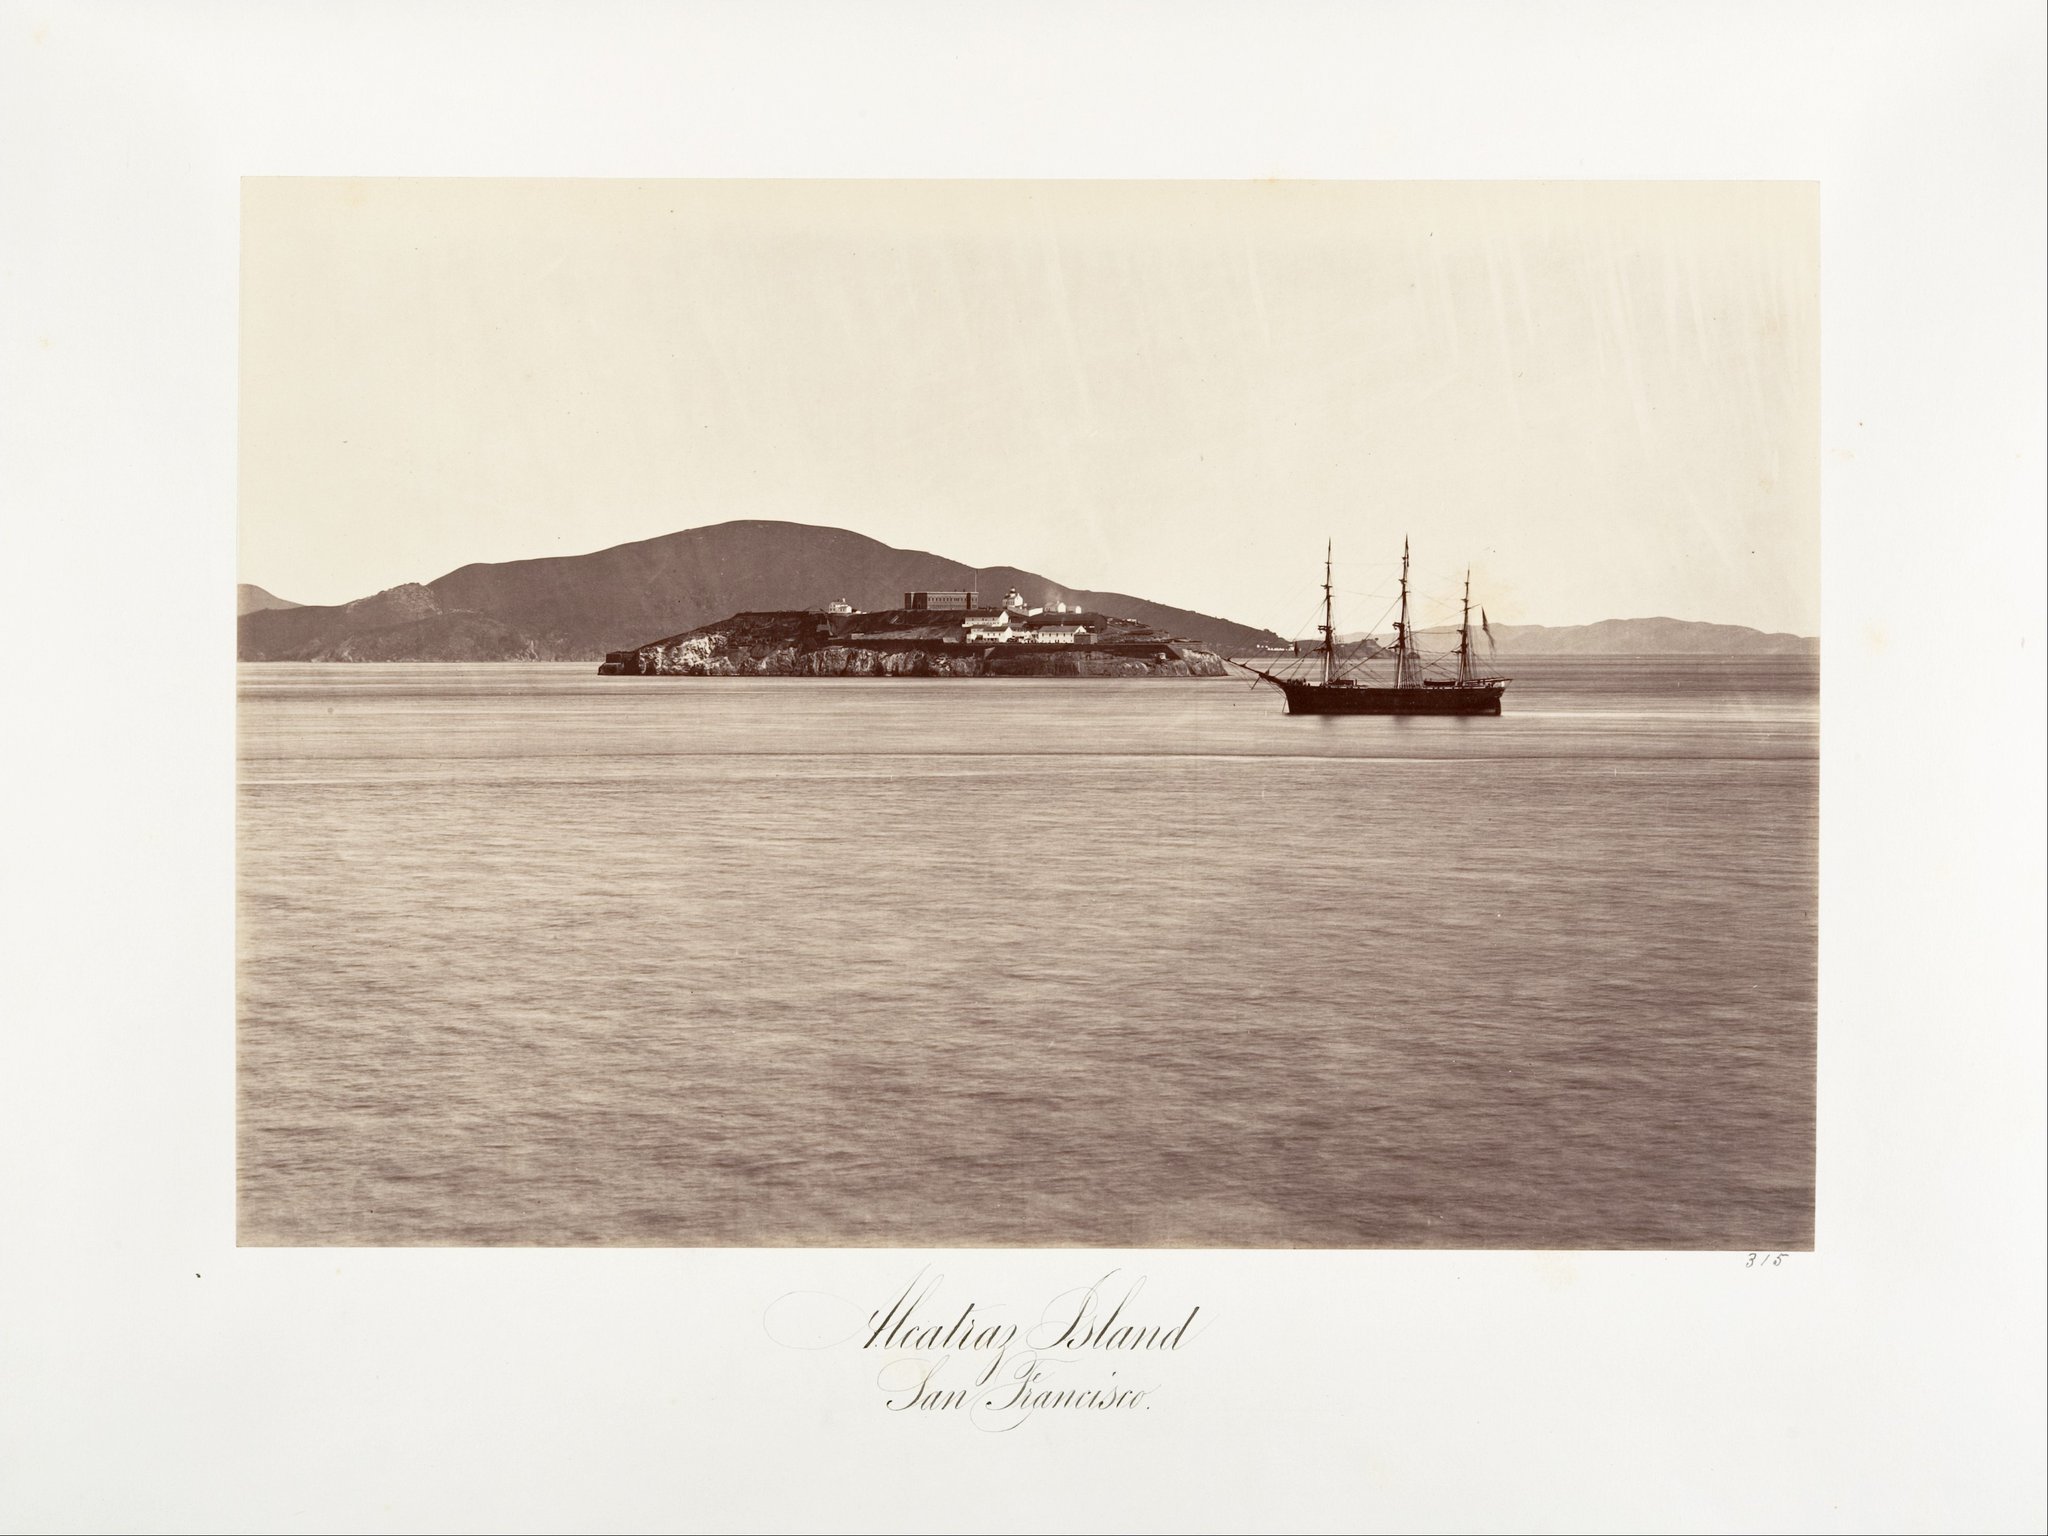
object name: photograph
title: Alcatraz Island, San Francisco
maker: carleton e. watkins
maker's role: artist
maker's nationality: american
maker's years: 1829-1916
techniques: albumen silver print, glass negative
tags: prisons,ships